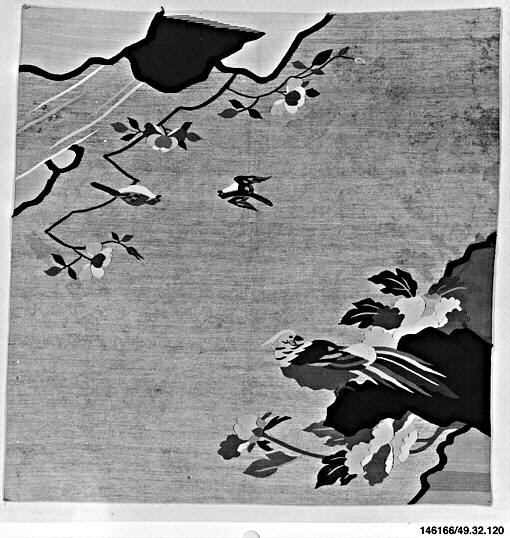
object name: gift cloth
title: Gift Cloth (Fukusa)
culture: japanese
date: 1701-1800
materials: metal thread, silk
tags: birds,flowers